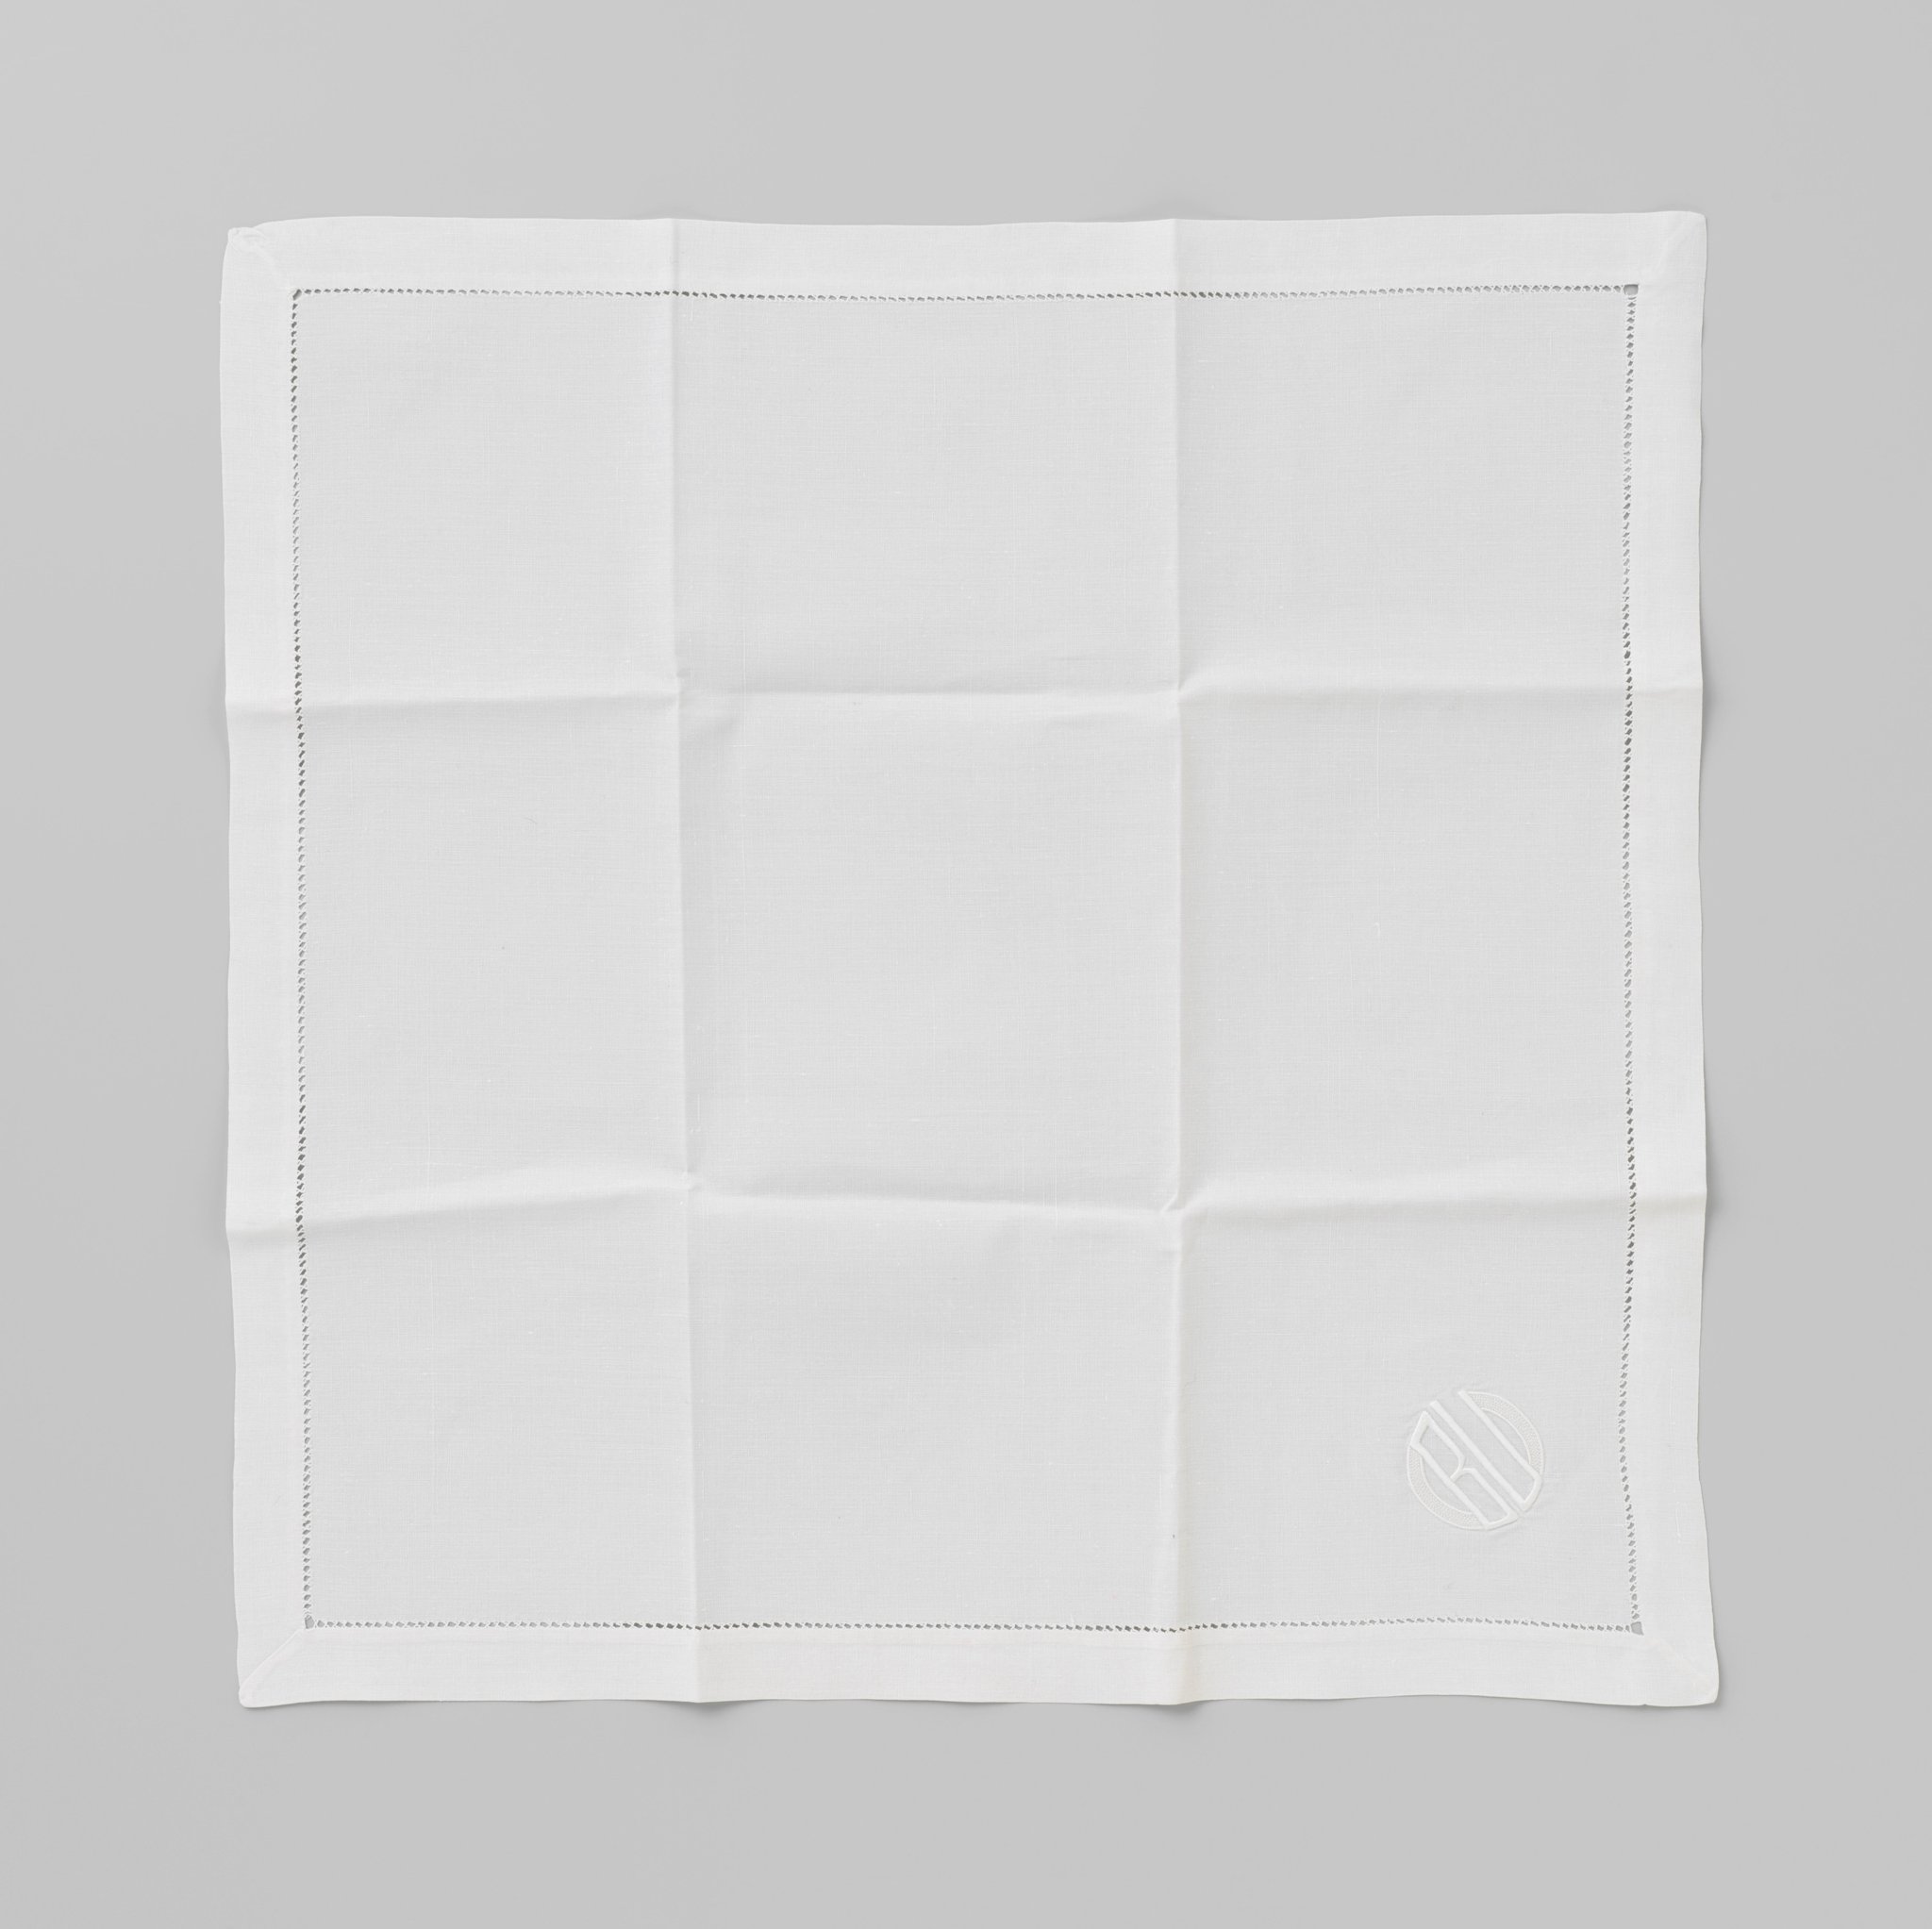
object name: napkin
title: Servet van linnen met de geborduurde initialen BU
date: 1935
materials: linen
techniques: embroidered, weave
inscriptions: initials: ‘BU’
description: Servet van linnen in platbinding, met opengewerkte zomen en de geborduurde initialen BU (Brusse-Urtebise).